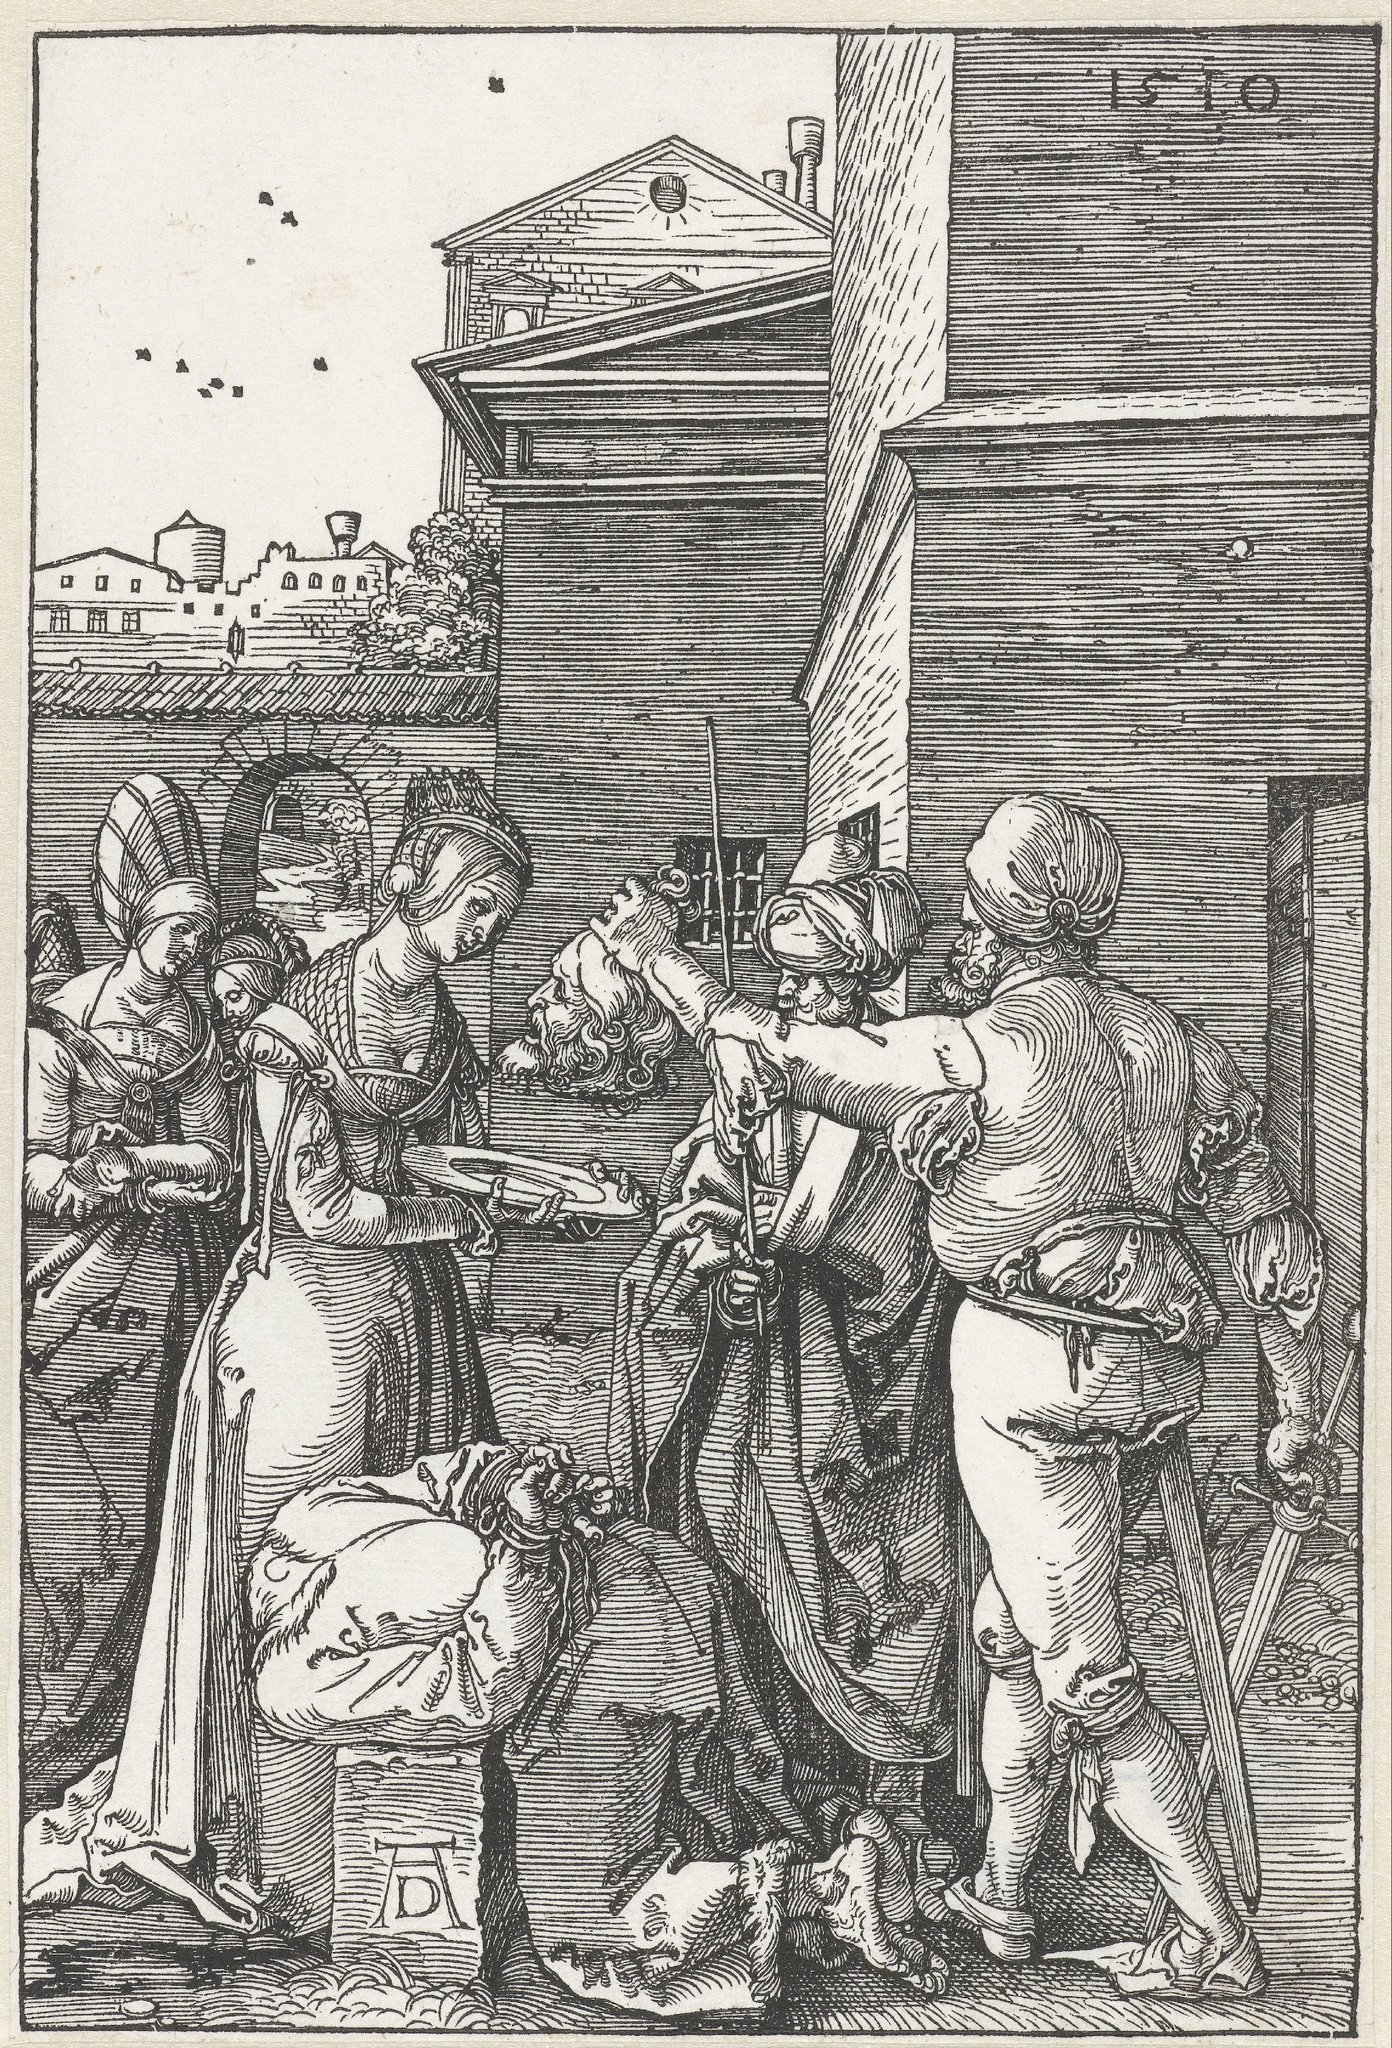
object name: print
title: De onthoofding van Johannes de Doper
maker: albrecht dürer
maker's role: draughtsman, painter, print maker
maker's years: 1471-1528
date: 1510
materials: paper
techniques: woodcut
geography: nuremberg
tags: salome is given the head of john the baptist by the executioner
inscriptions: collector's mark: Lugt 240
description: Een beul legt het hoofd van Johannes de Doper op een schaal die een vrouw (Salome) vasthoudt. Het onthoofde lichaam van Johannes ligt voor haar op een blok.